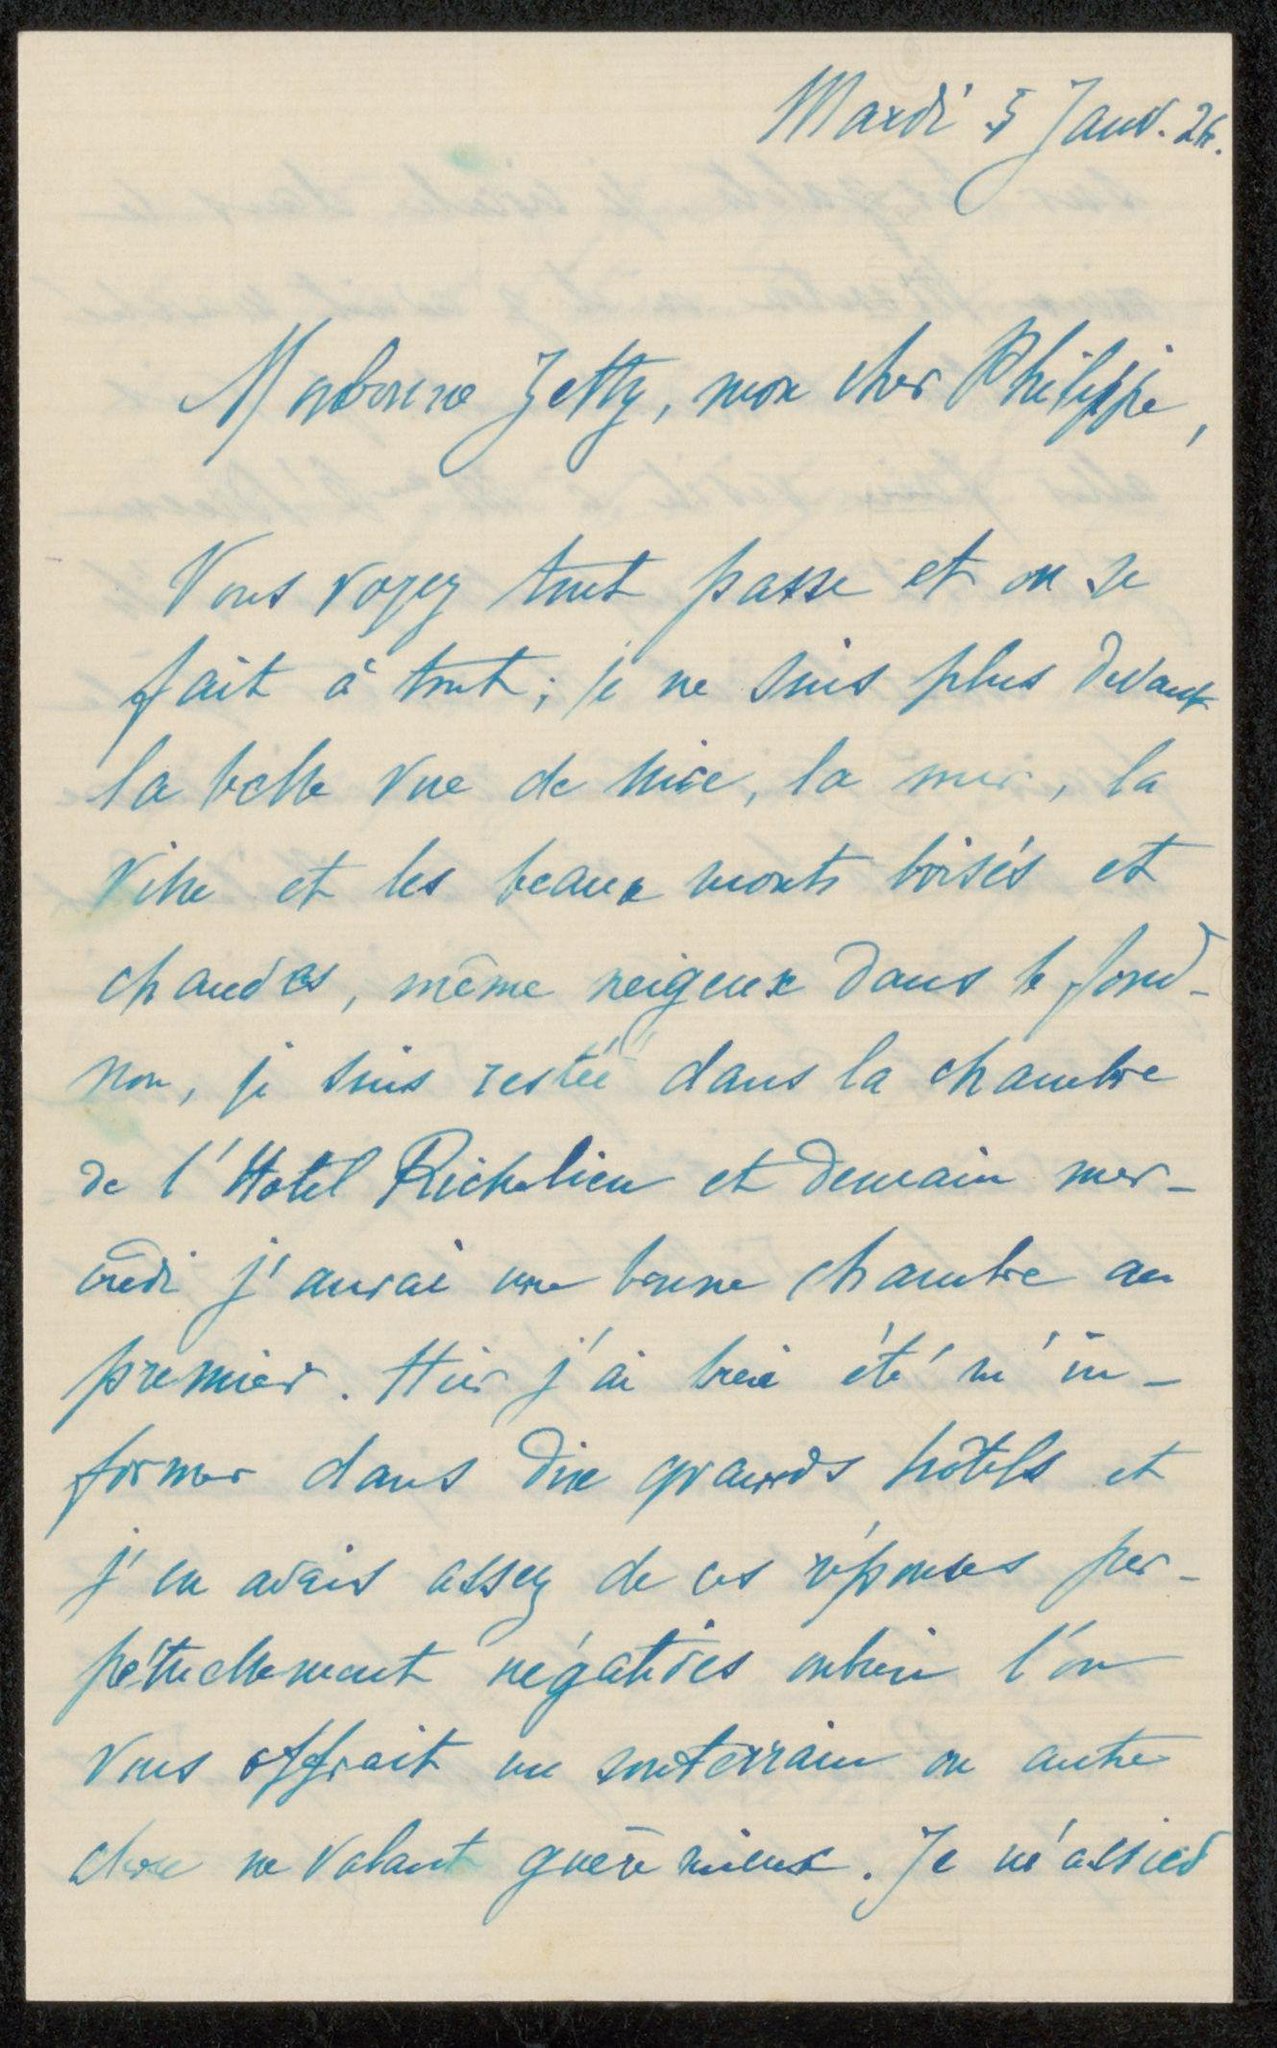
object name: letter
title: Brief aan Philip Zilcken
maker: jeanne boels de buck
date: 1924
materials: ink, paper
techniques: pen, writing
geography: menton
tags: painter, draughtsman, philip zilcken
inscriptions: collector's mark: ‘RPK’